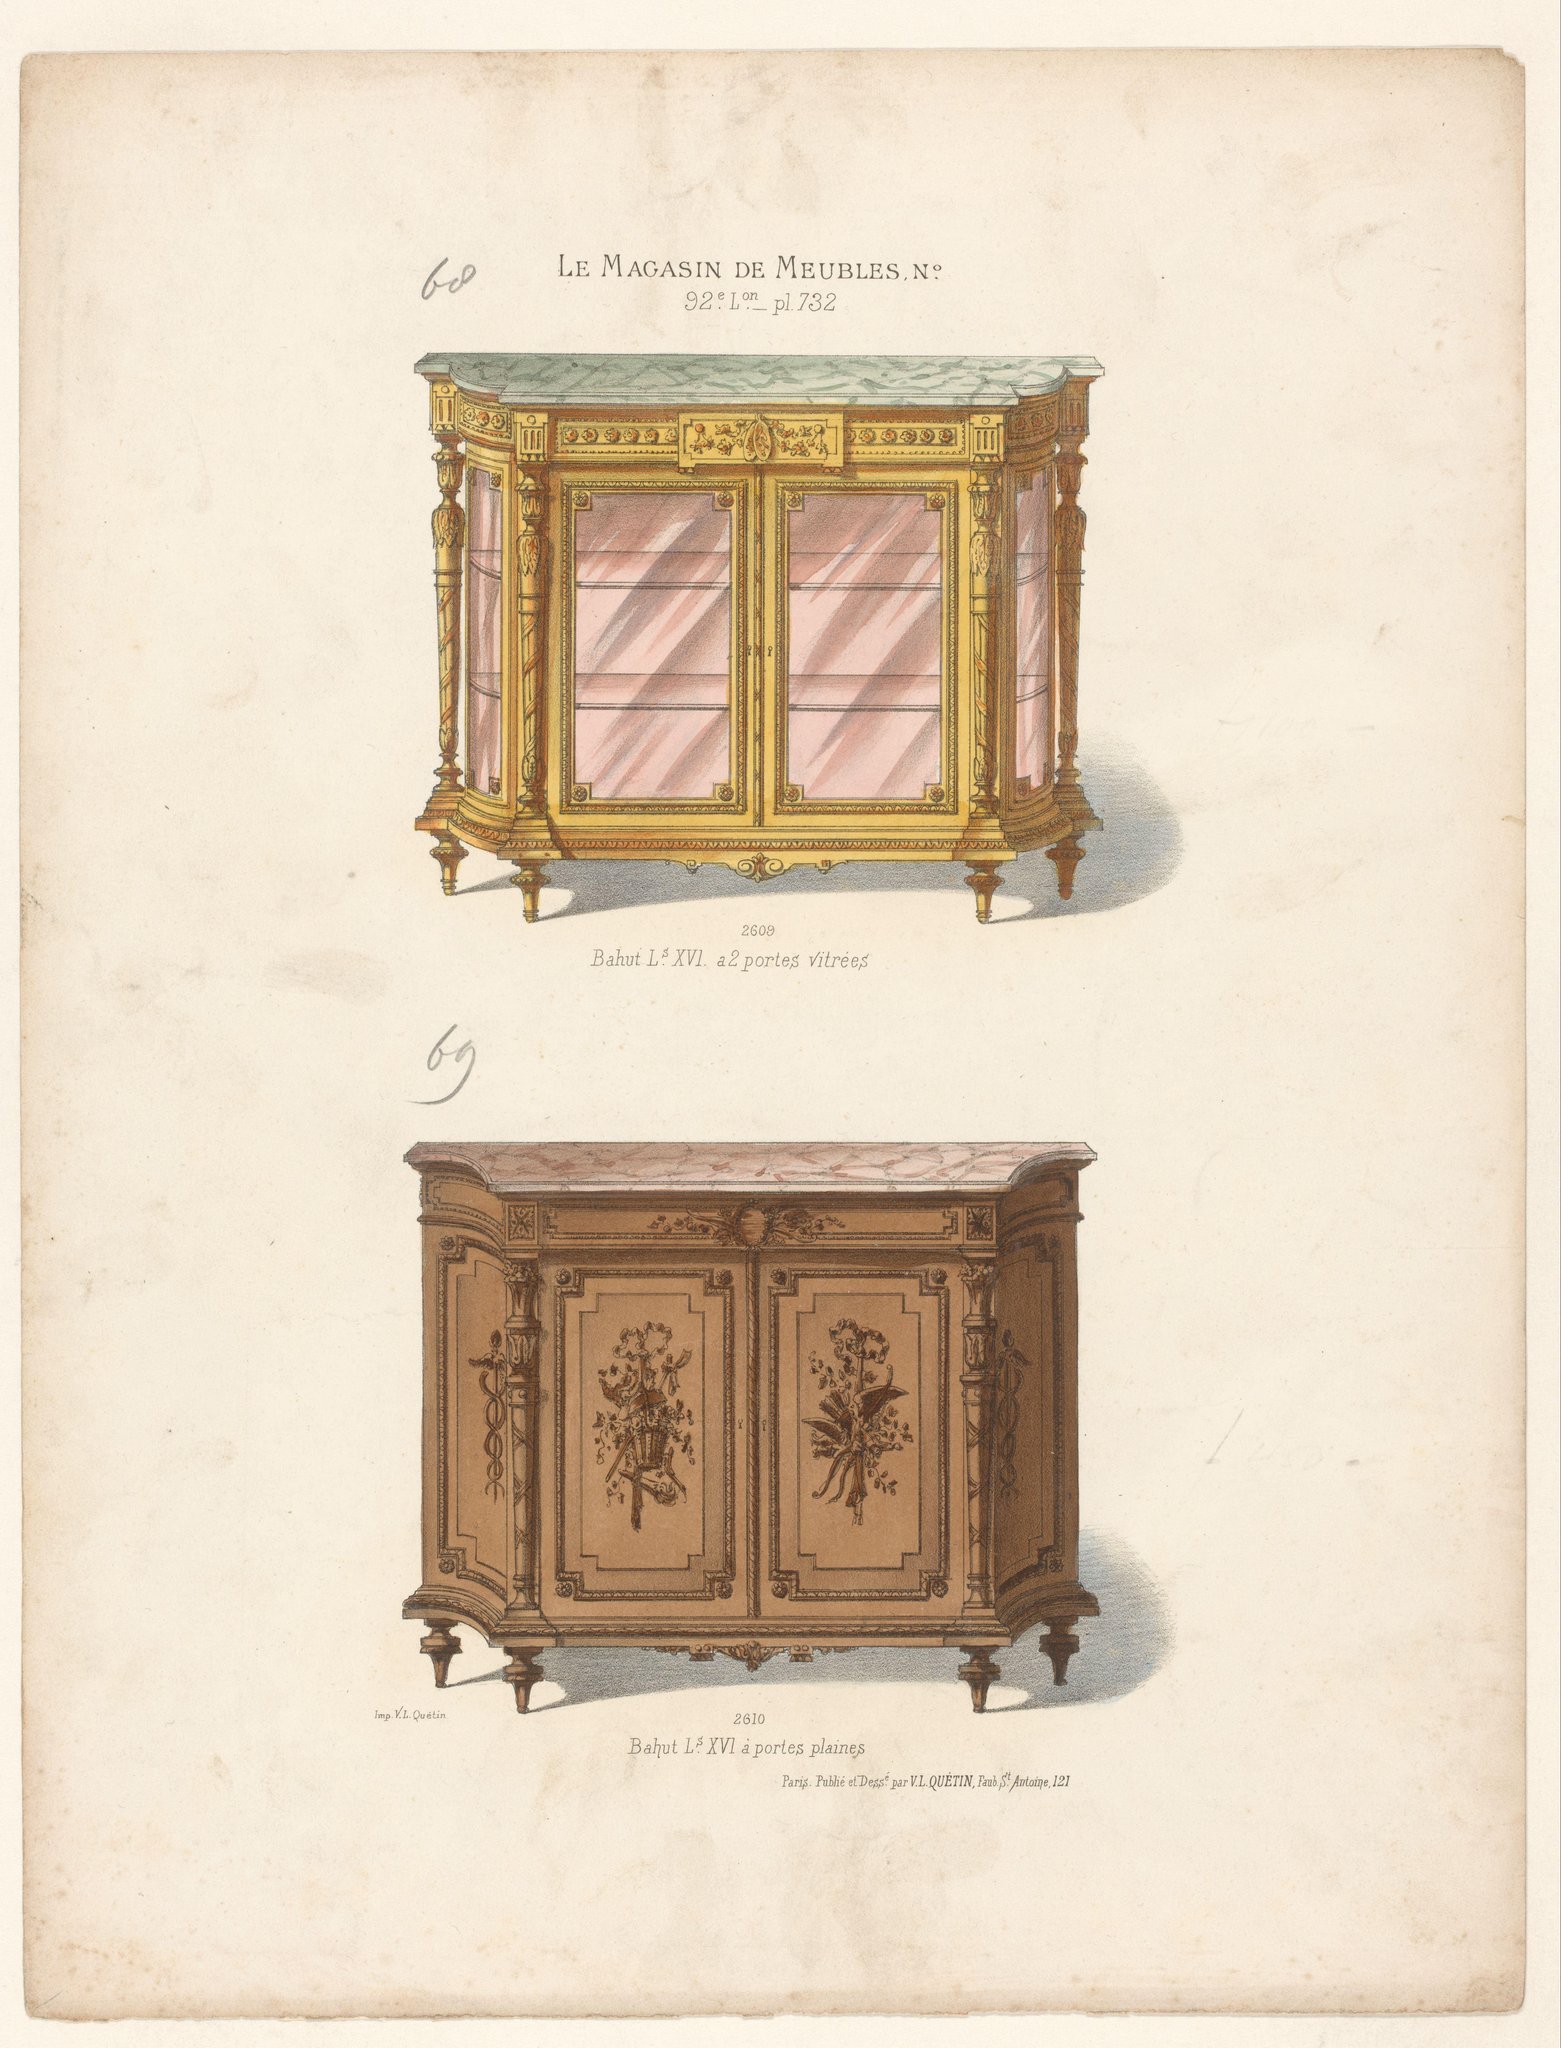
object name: print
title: Le Magasin de Meubles No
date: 1878-1904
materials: paper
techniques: hand coloring, lithograph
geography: paris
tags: furniture for storage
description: Twee kasten in de Lodewijk XVI-stijl, waarvan één met glazen deuren. Prent uit 92e Livraison.